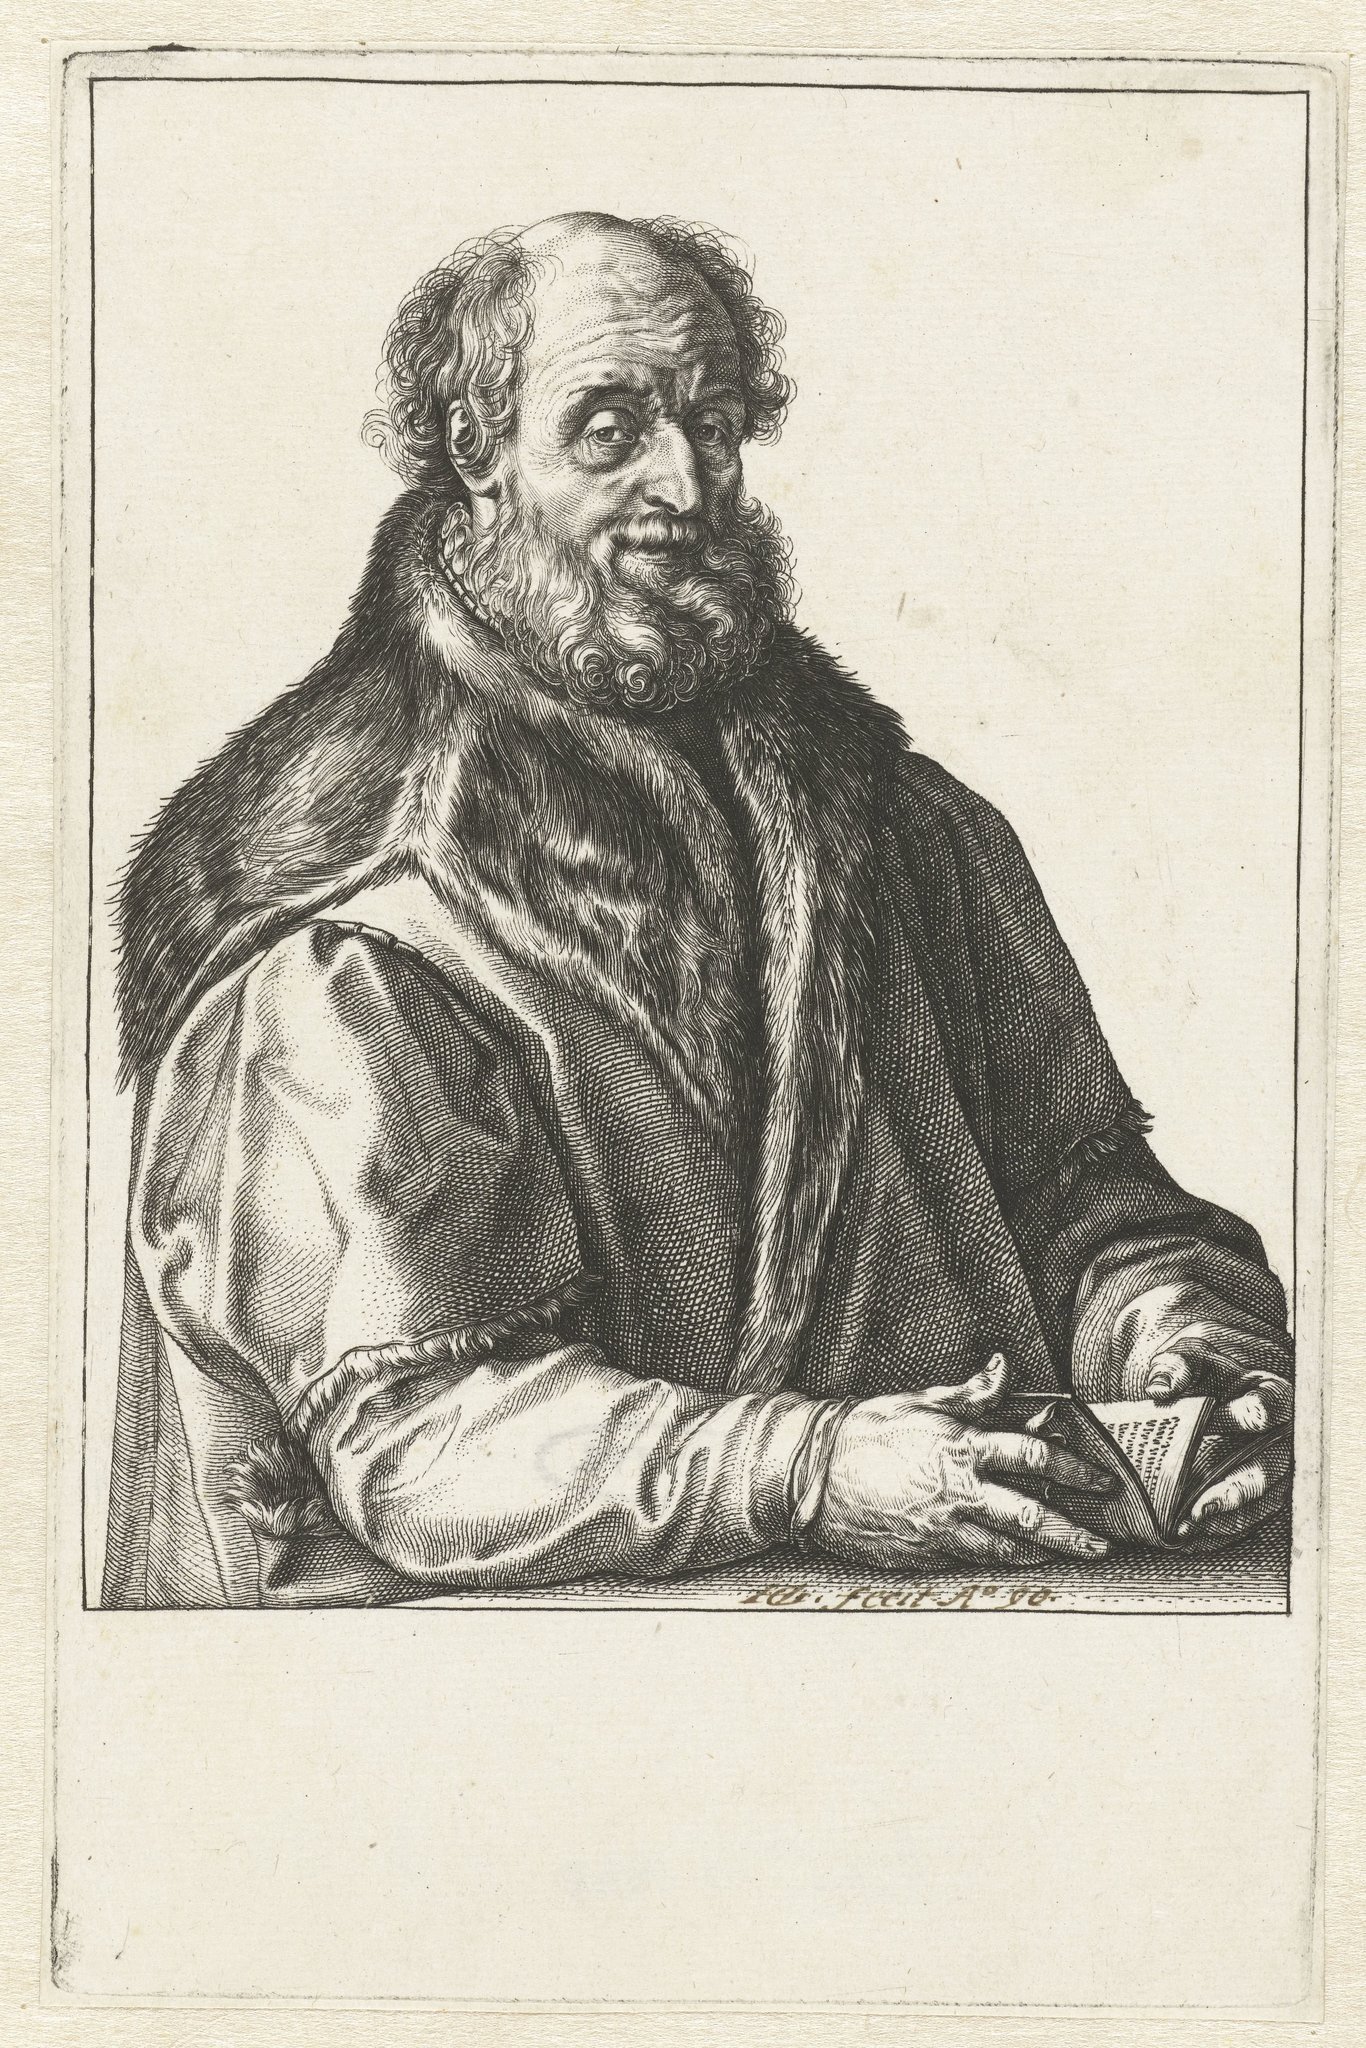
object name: print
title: Portret van Jan van Suren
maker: hendrick goltzius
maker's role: draughtsman, painter, print maker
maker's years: 1558-1617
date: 1588-1590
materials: paper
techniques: engraving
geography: haarlem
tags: historical persons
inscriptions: collector's mark: Lugt 964, inscription: ‘HG. fecit Ao 90.’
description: Portret van de drukker/uitgever en burgemeester van Haarlem, Jan van Suren (1517-1591). Van Suren is hier 71 jaar oud. Ten halven lijve afgebeeld achter een tafel, min of meer op de rechterzijde gezien, de blik naar de beschouwer. In zijn handen een boekje. Hij is gekleed in een mantel afgezet met bont.